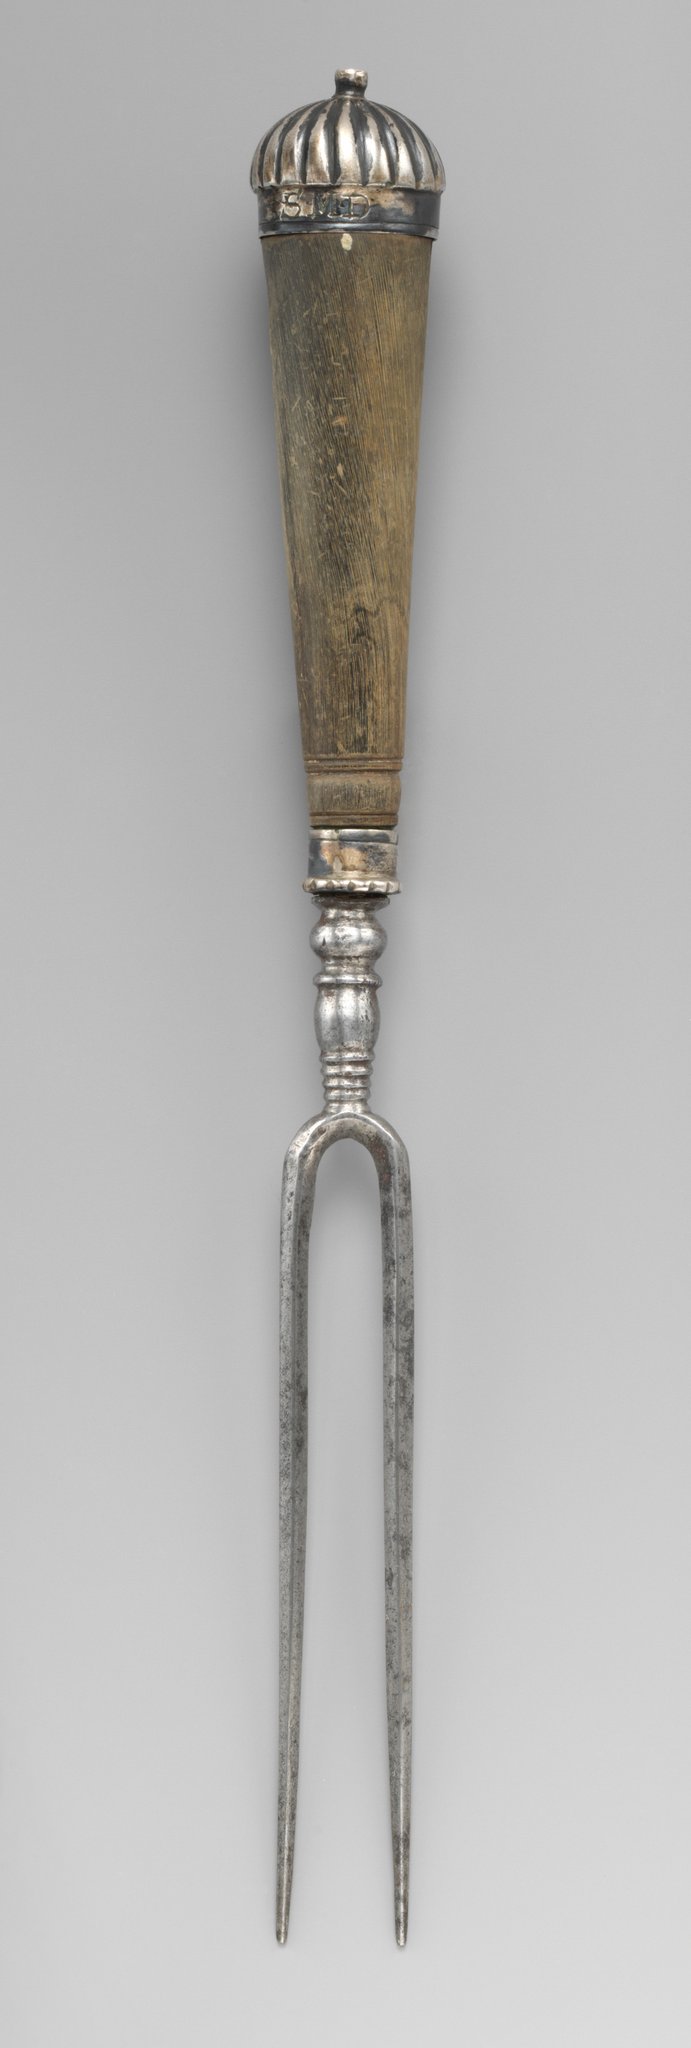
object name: table fork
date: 1601-1700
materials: horn, silver, steel